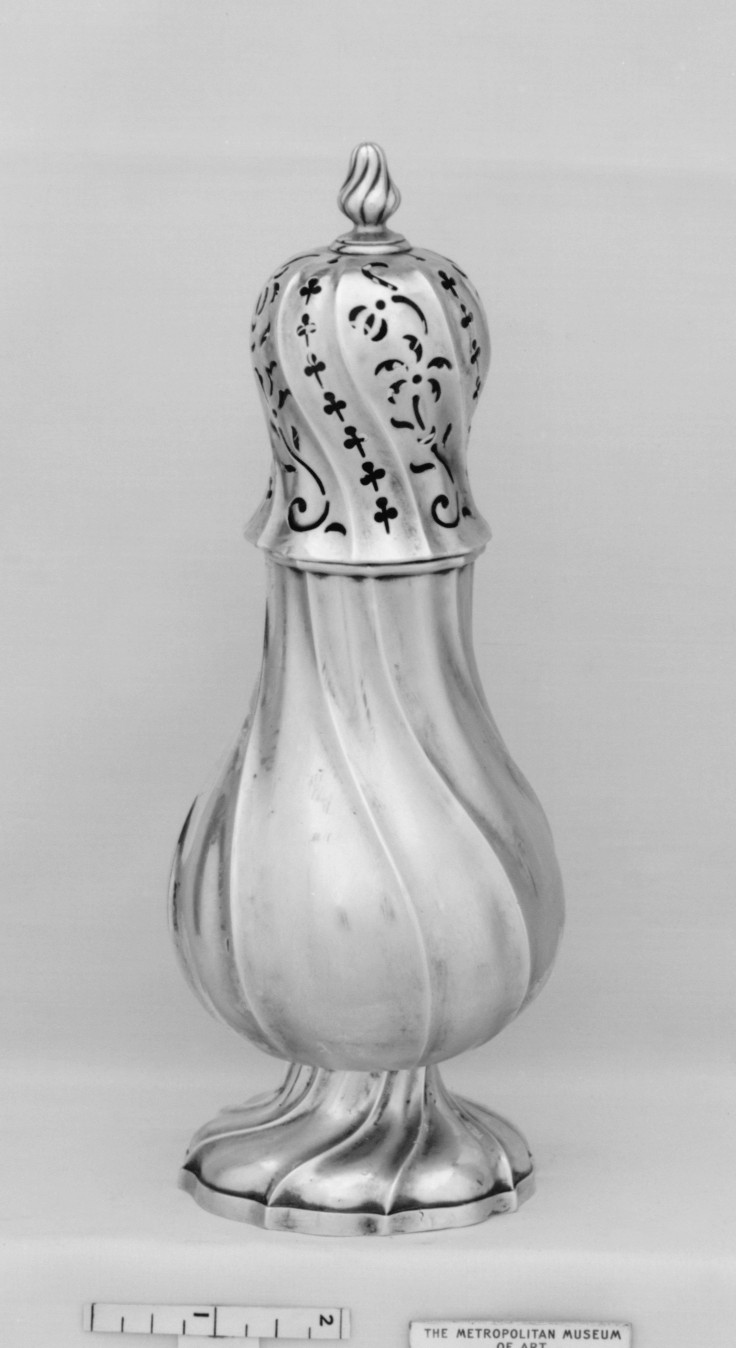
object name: caster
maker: motthijs croyenschot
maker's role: maker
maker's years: 1714-1796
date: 1769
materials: silver